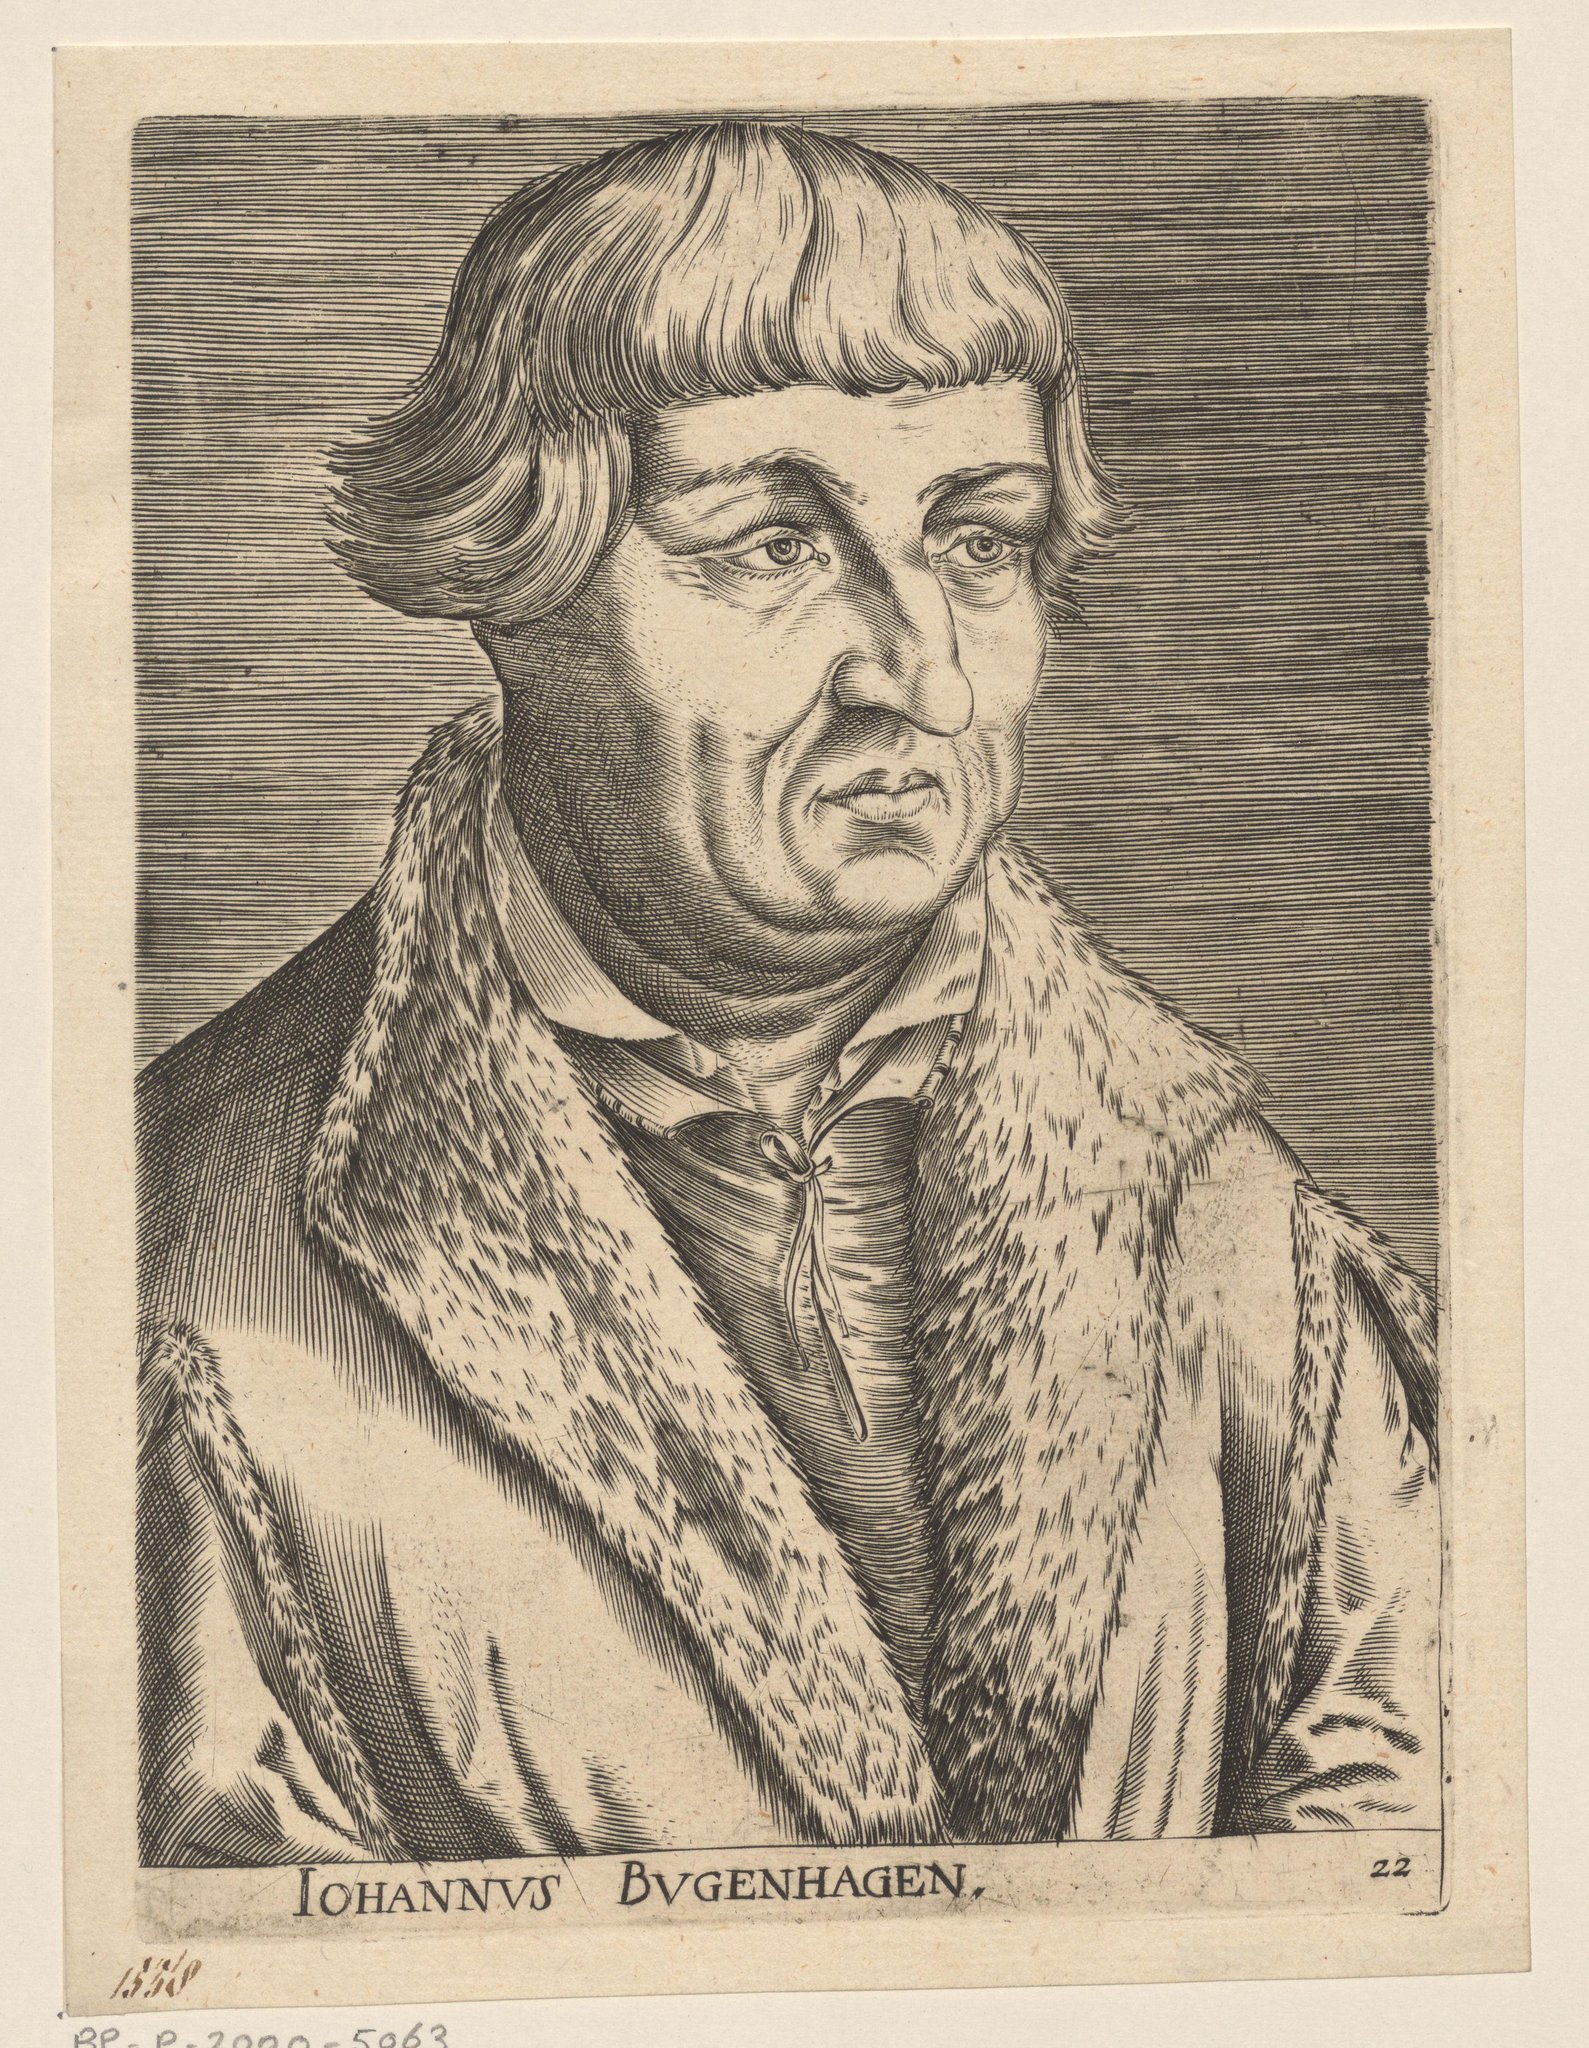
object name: print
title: Portret van Johannes Bugenhagen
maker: Anonymous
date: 1600-1649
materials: paper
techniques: engraving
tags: theologian, historical persons